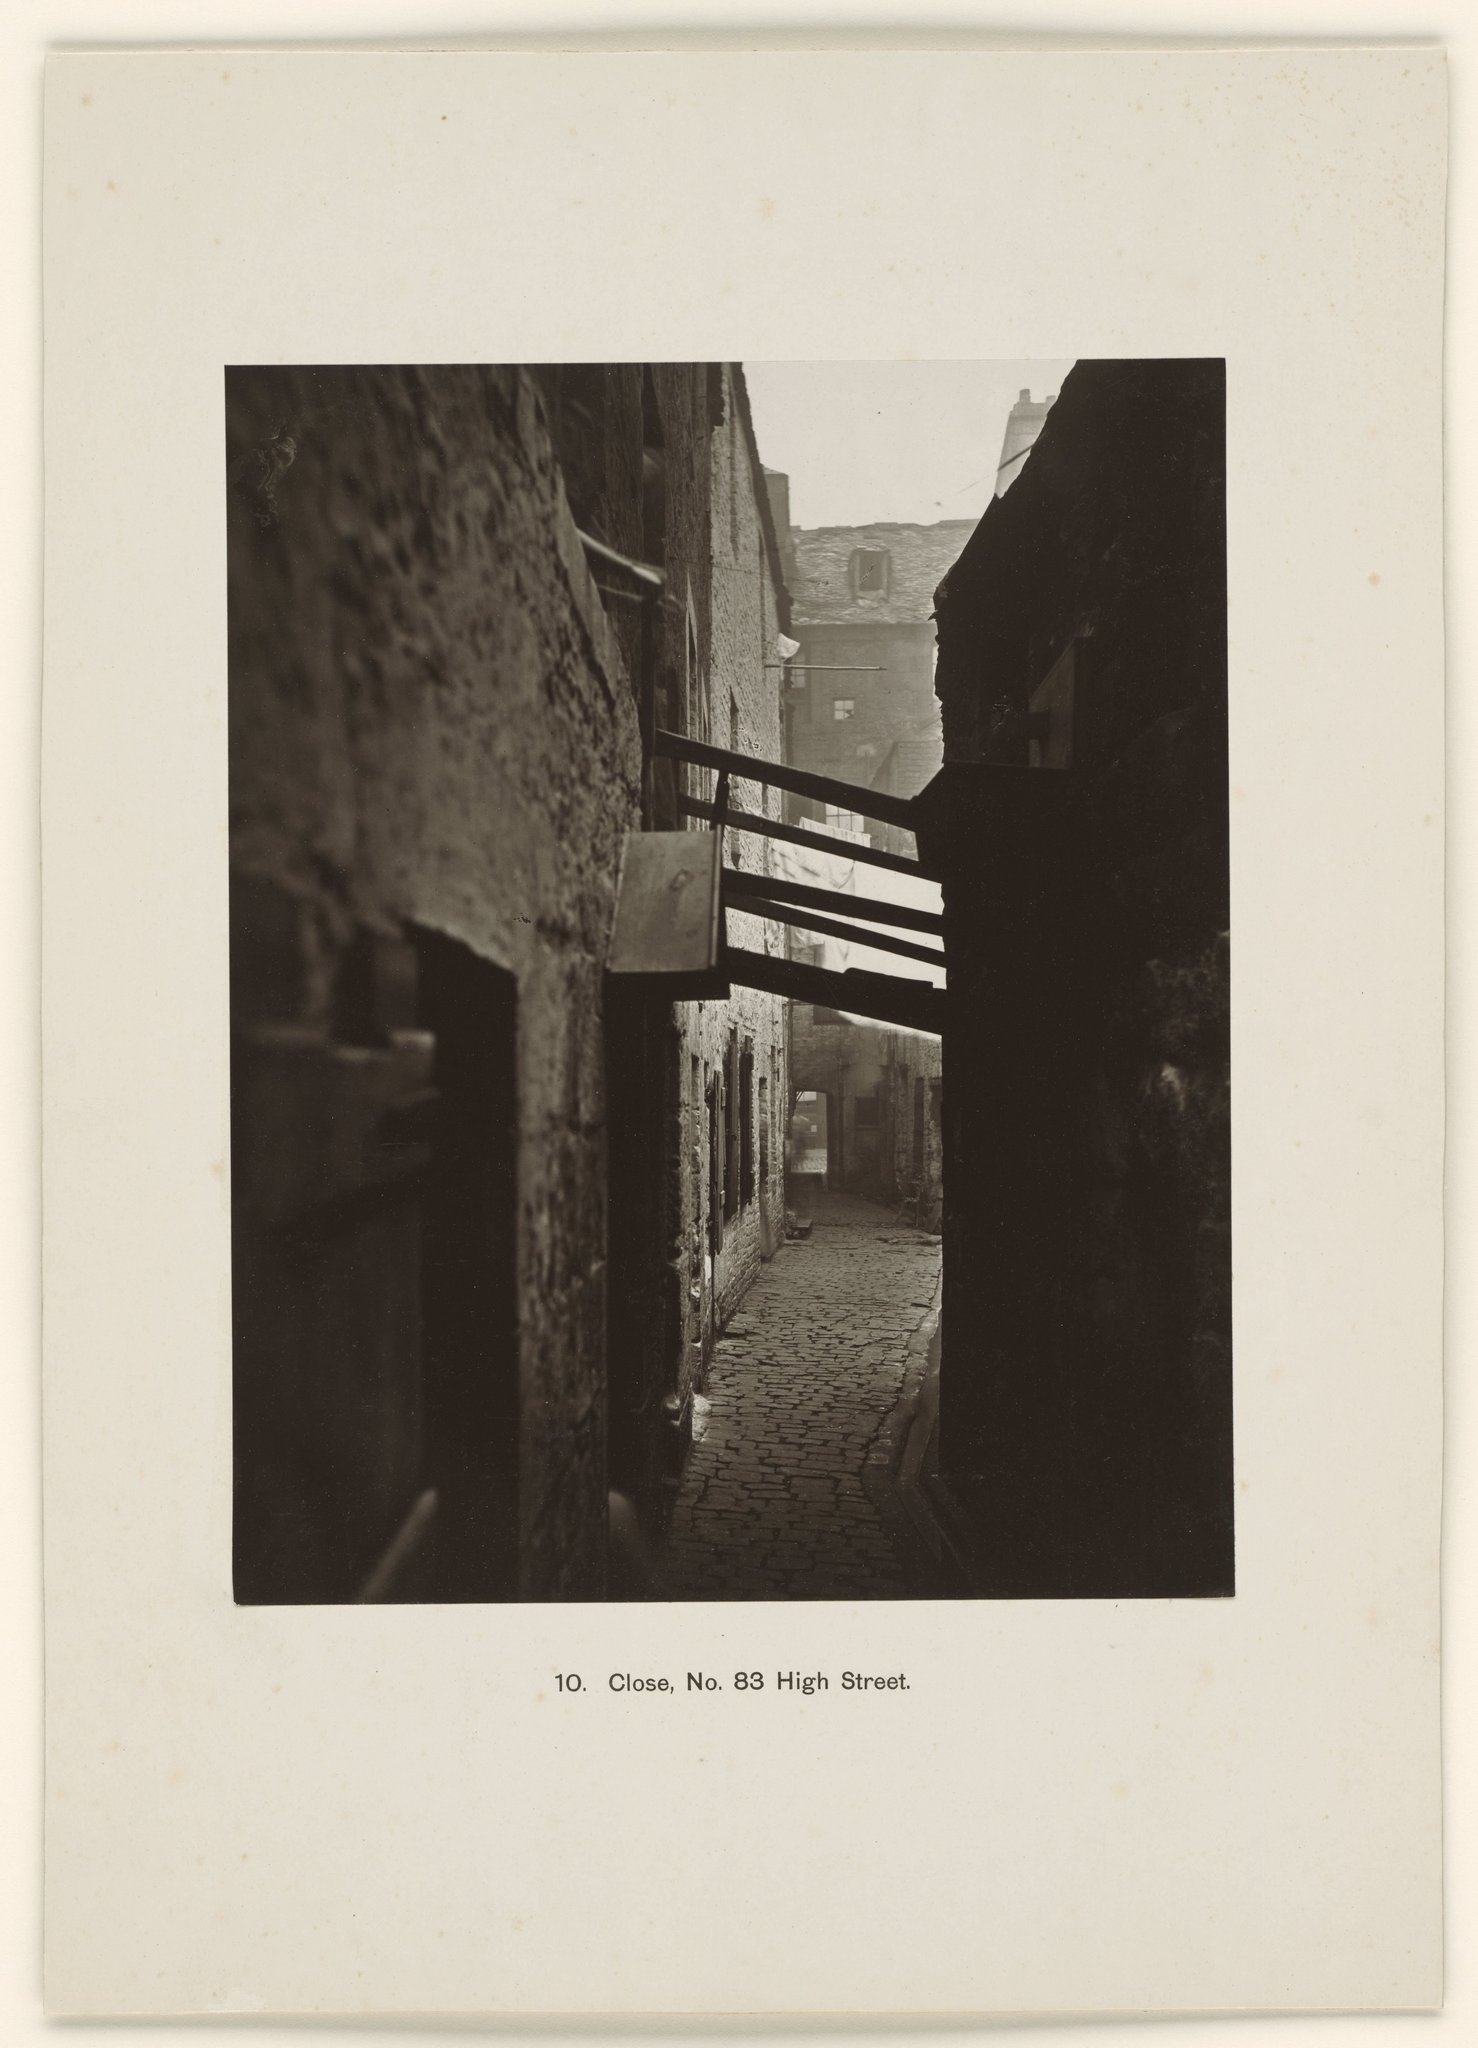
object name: photograph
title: The Slums of Glasgow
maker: thomas annan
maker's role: fotograaf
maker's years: 1829-1887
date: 1868-1877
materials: cardboard, photographic support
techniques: carbon print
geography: glasgow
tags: lane, alley, glasgow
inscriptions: number: ‘10.’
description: In 1866 Annan purchased for Scotland the patent rights to Joseph Swan’s permanent carbon process to improve the photographic art reproductions he specialized in. As it turned out, his fame rests on the series of slums and alleys of Glasgow that he documented on commission from the Glasgow City Improvement Trust as of 1868. In 1877 he printed 60 sets (of the series of 40 photographs) as carbon prints.